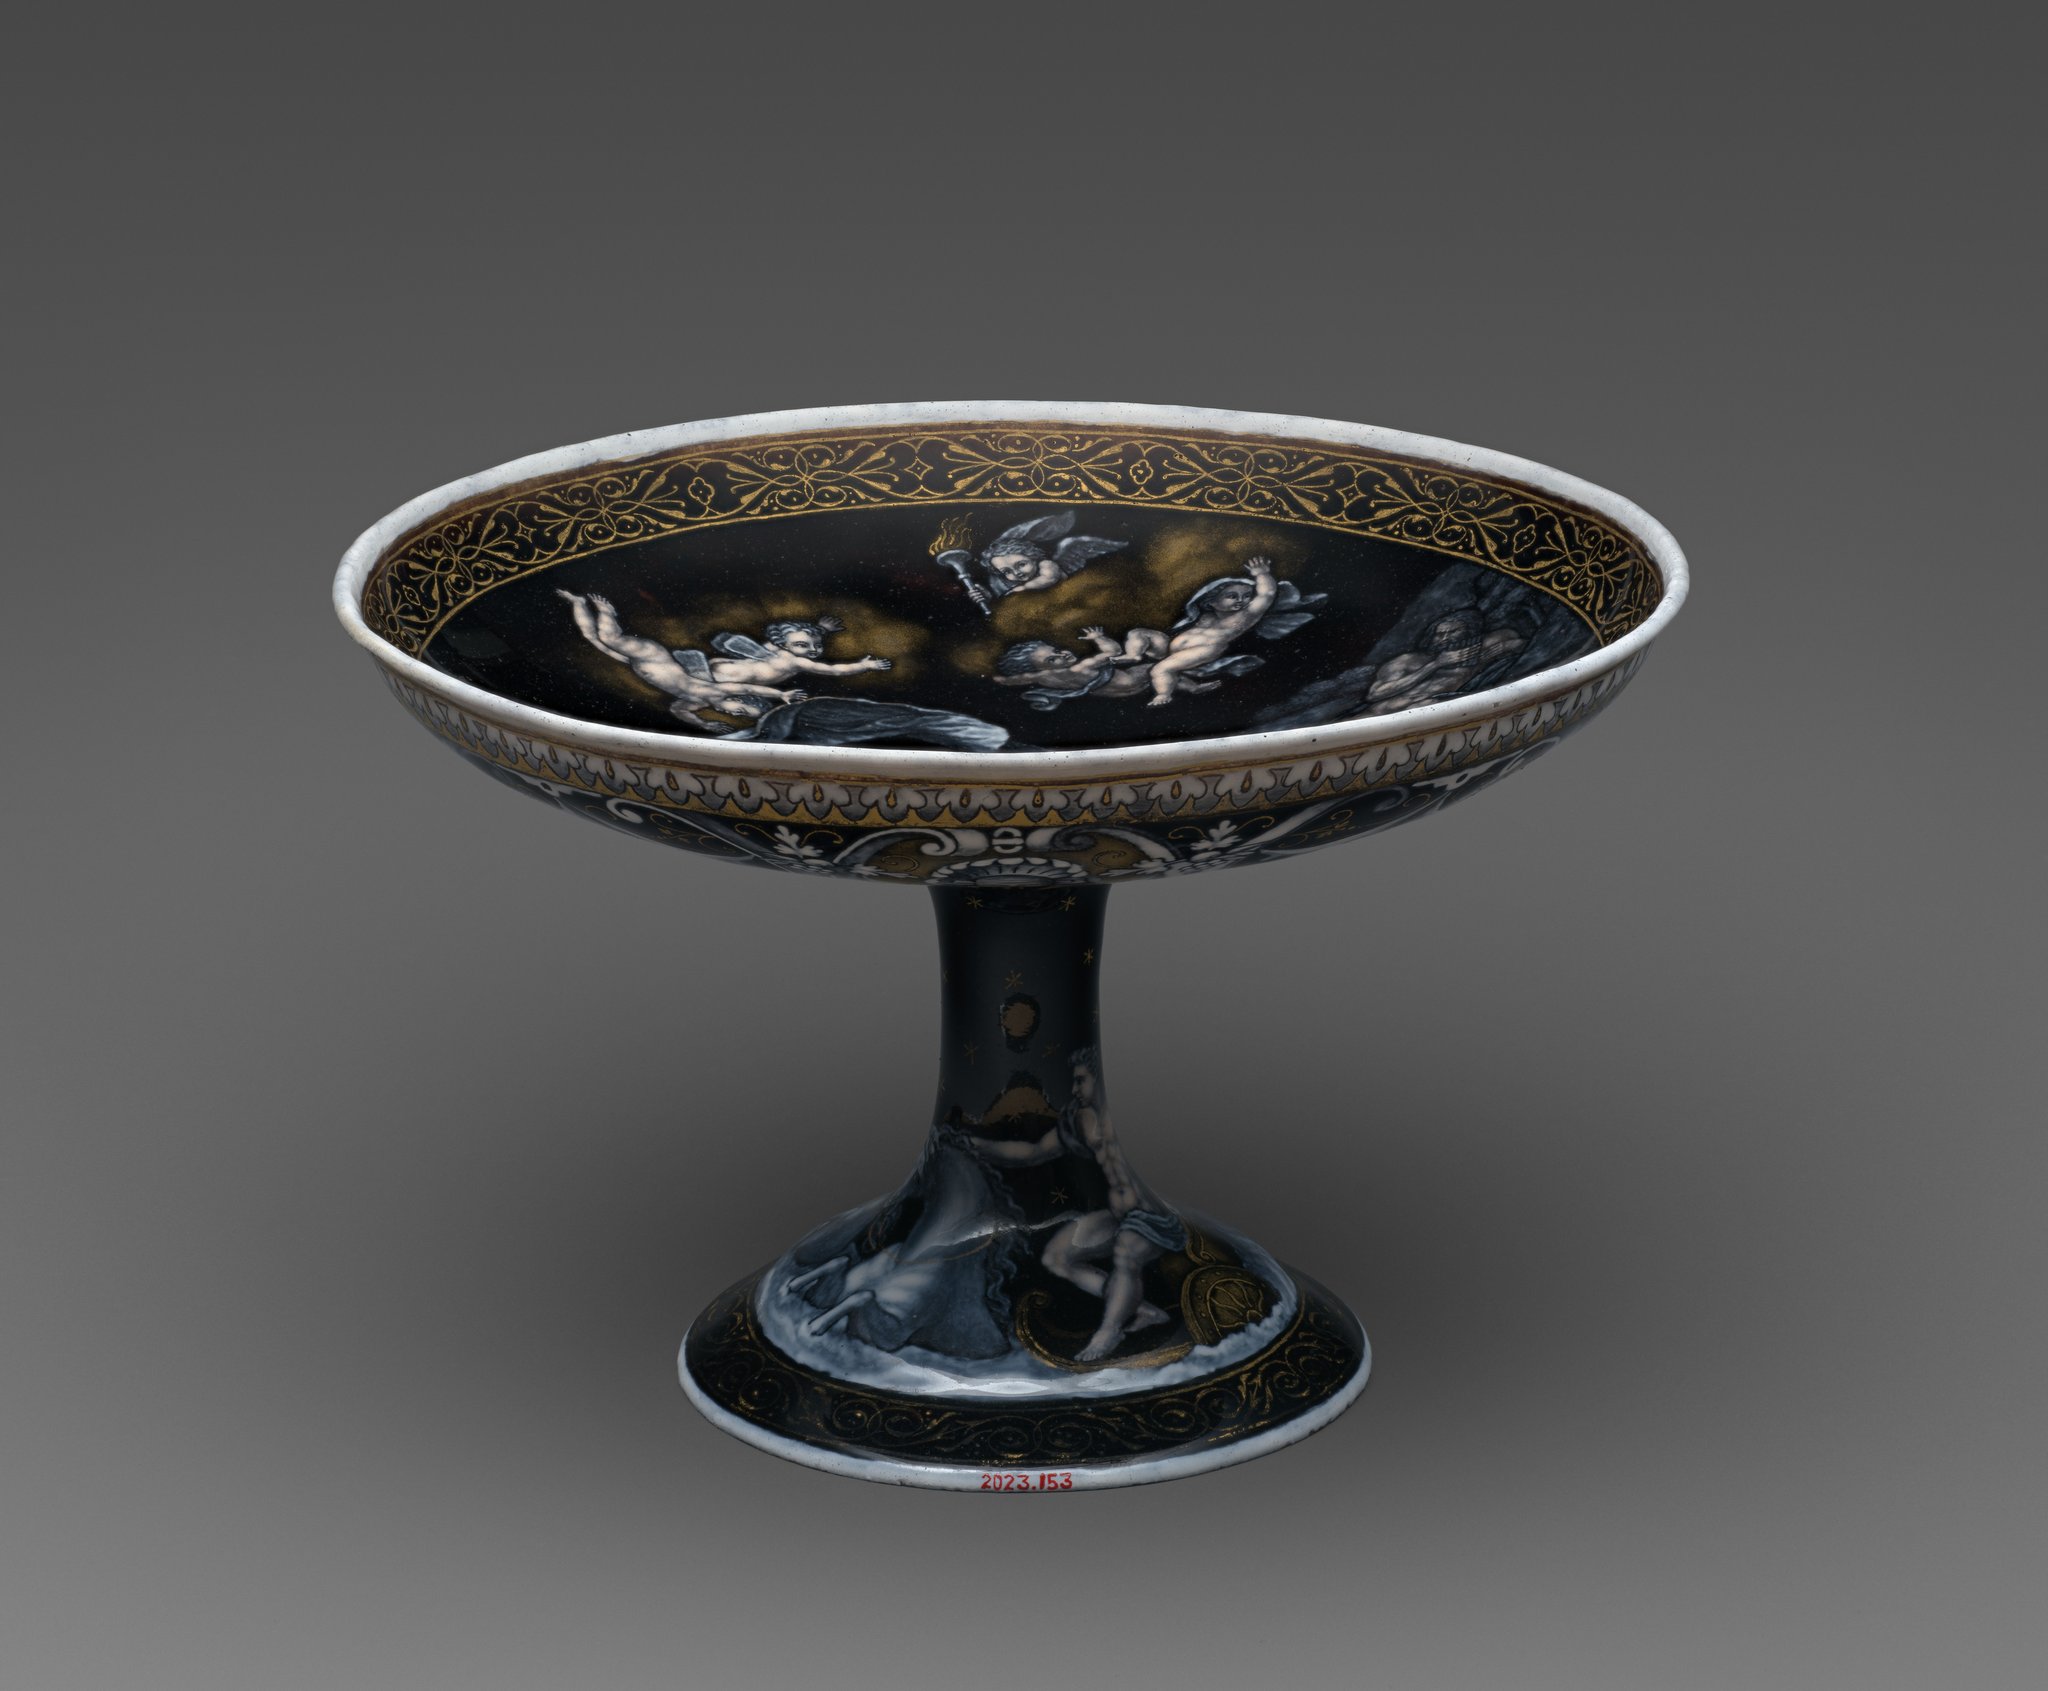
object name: cup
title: Cup with the Triumph of Galatea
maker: charles-ludovic crétineau-joly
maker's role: artist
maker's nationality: french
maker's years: 1831-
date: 1863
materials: copper, enamel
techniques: painting